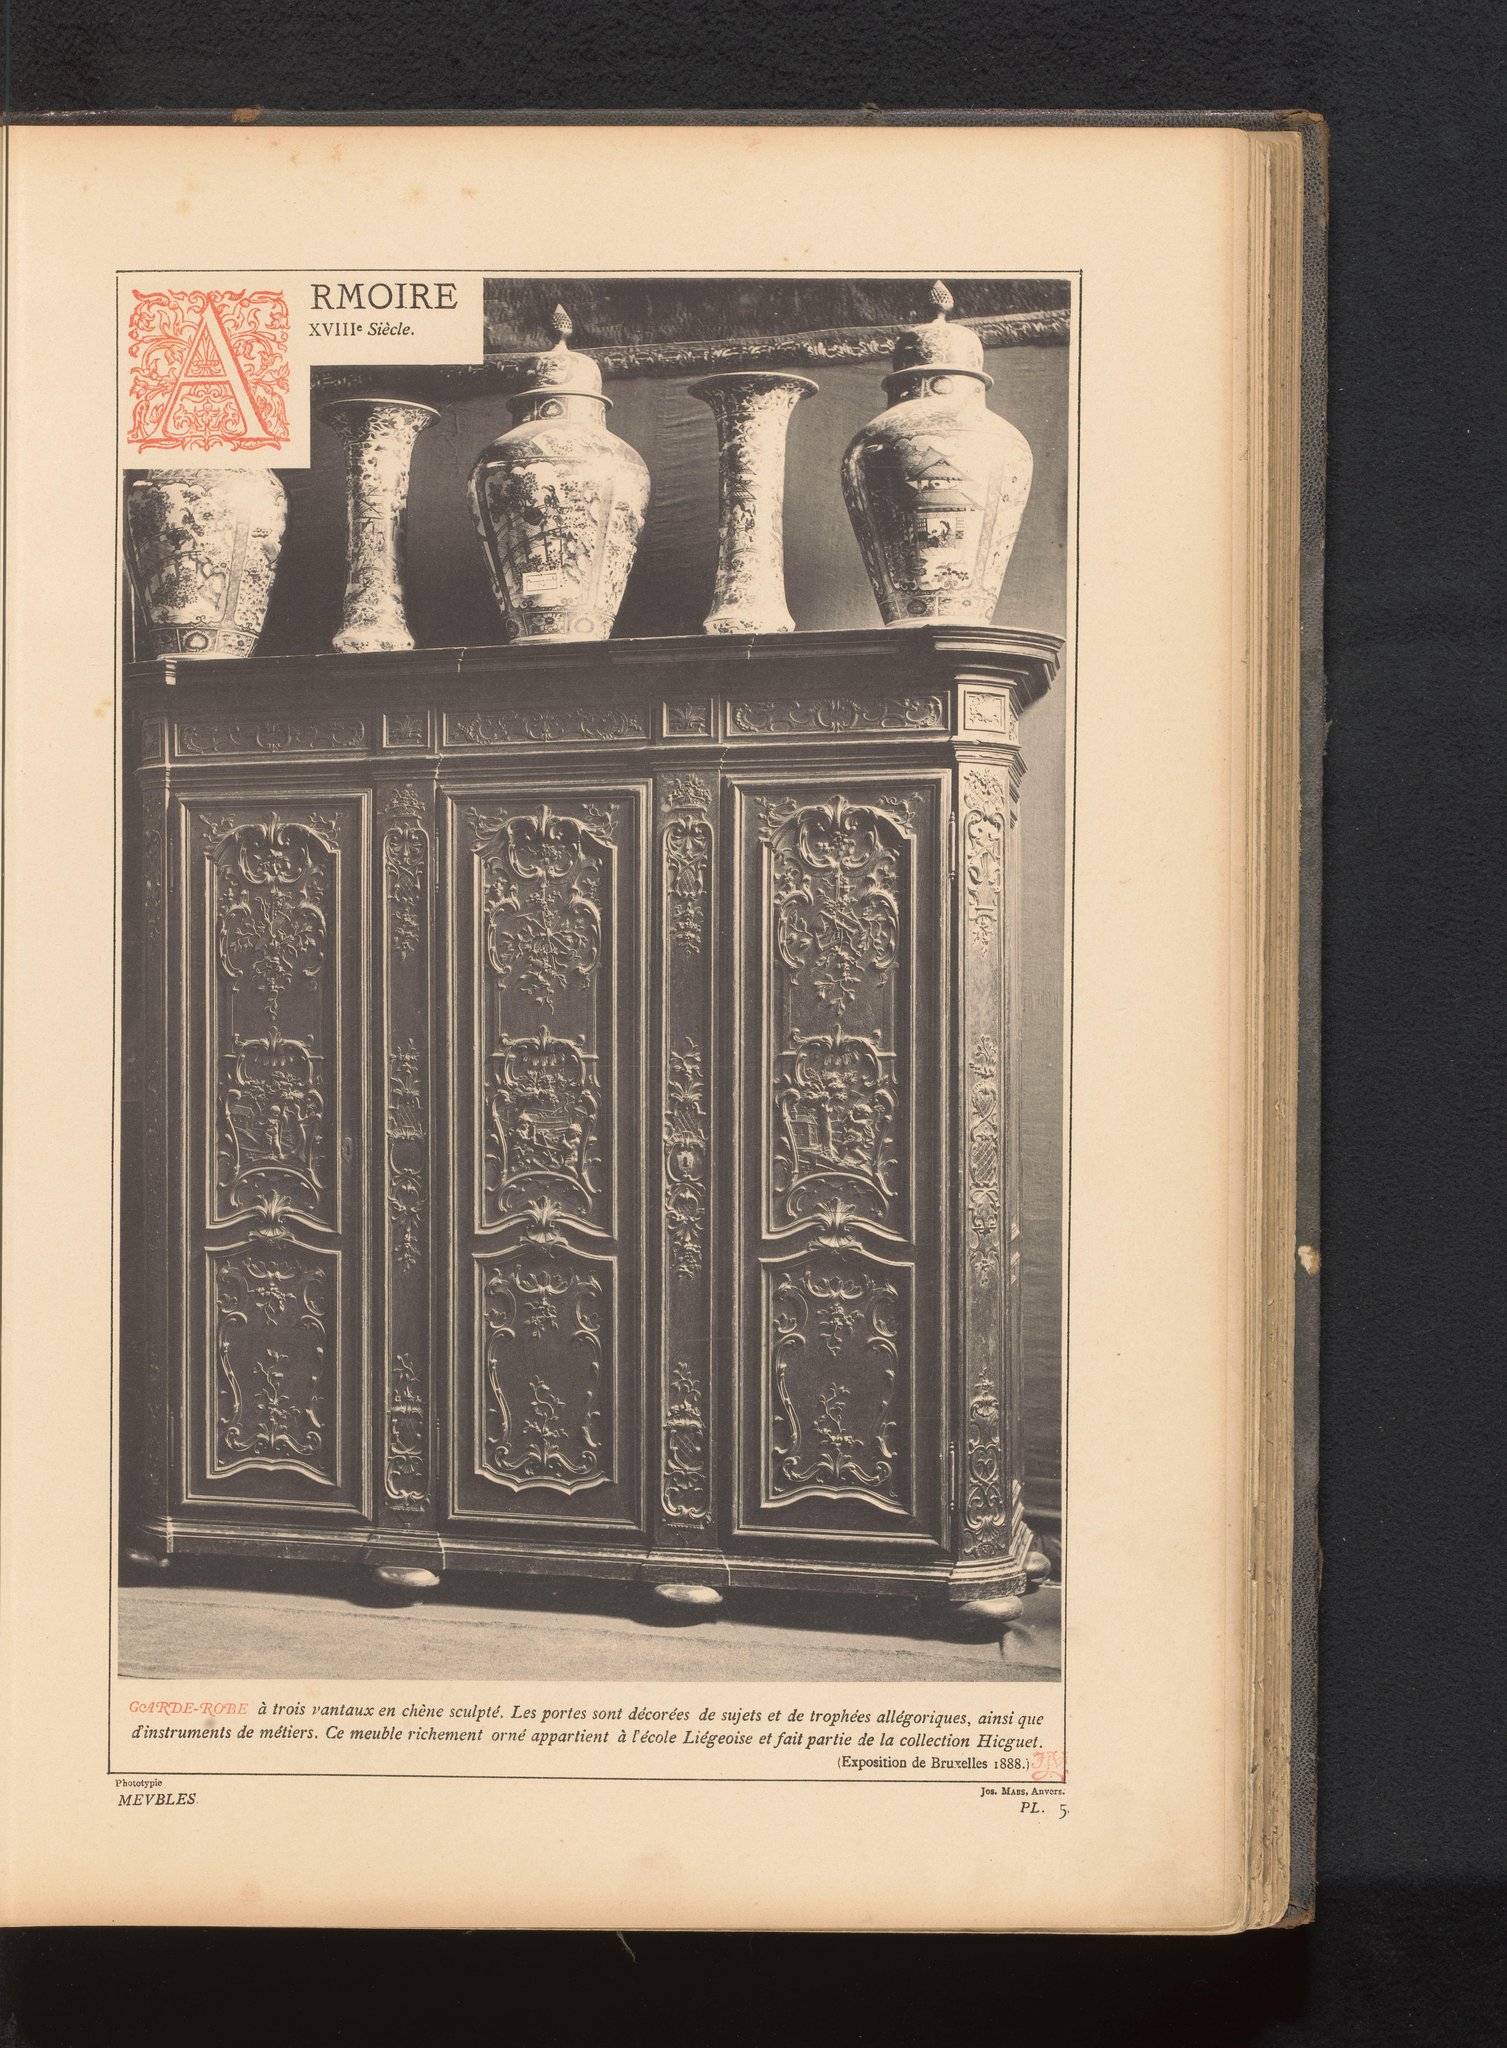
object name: page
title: Kledingkast van eikenhout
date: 1881-1889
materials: paper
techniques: photograph, photolithography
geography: antwerp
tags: wardrobe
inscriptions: inscription: ‘GARDE-ROBE à trois (...)’, monogram: ‘JJvY’, inscription: ‘MEUBLES. PL. 5.’